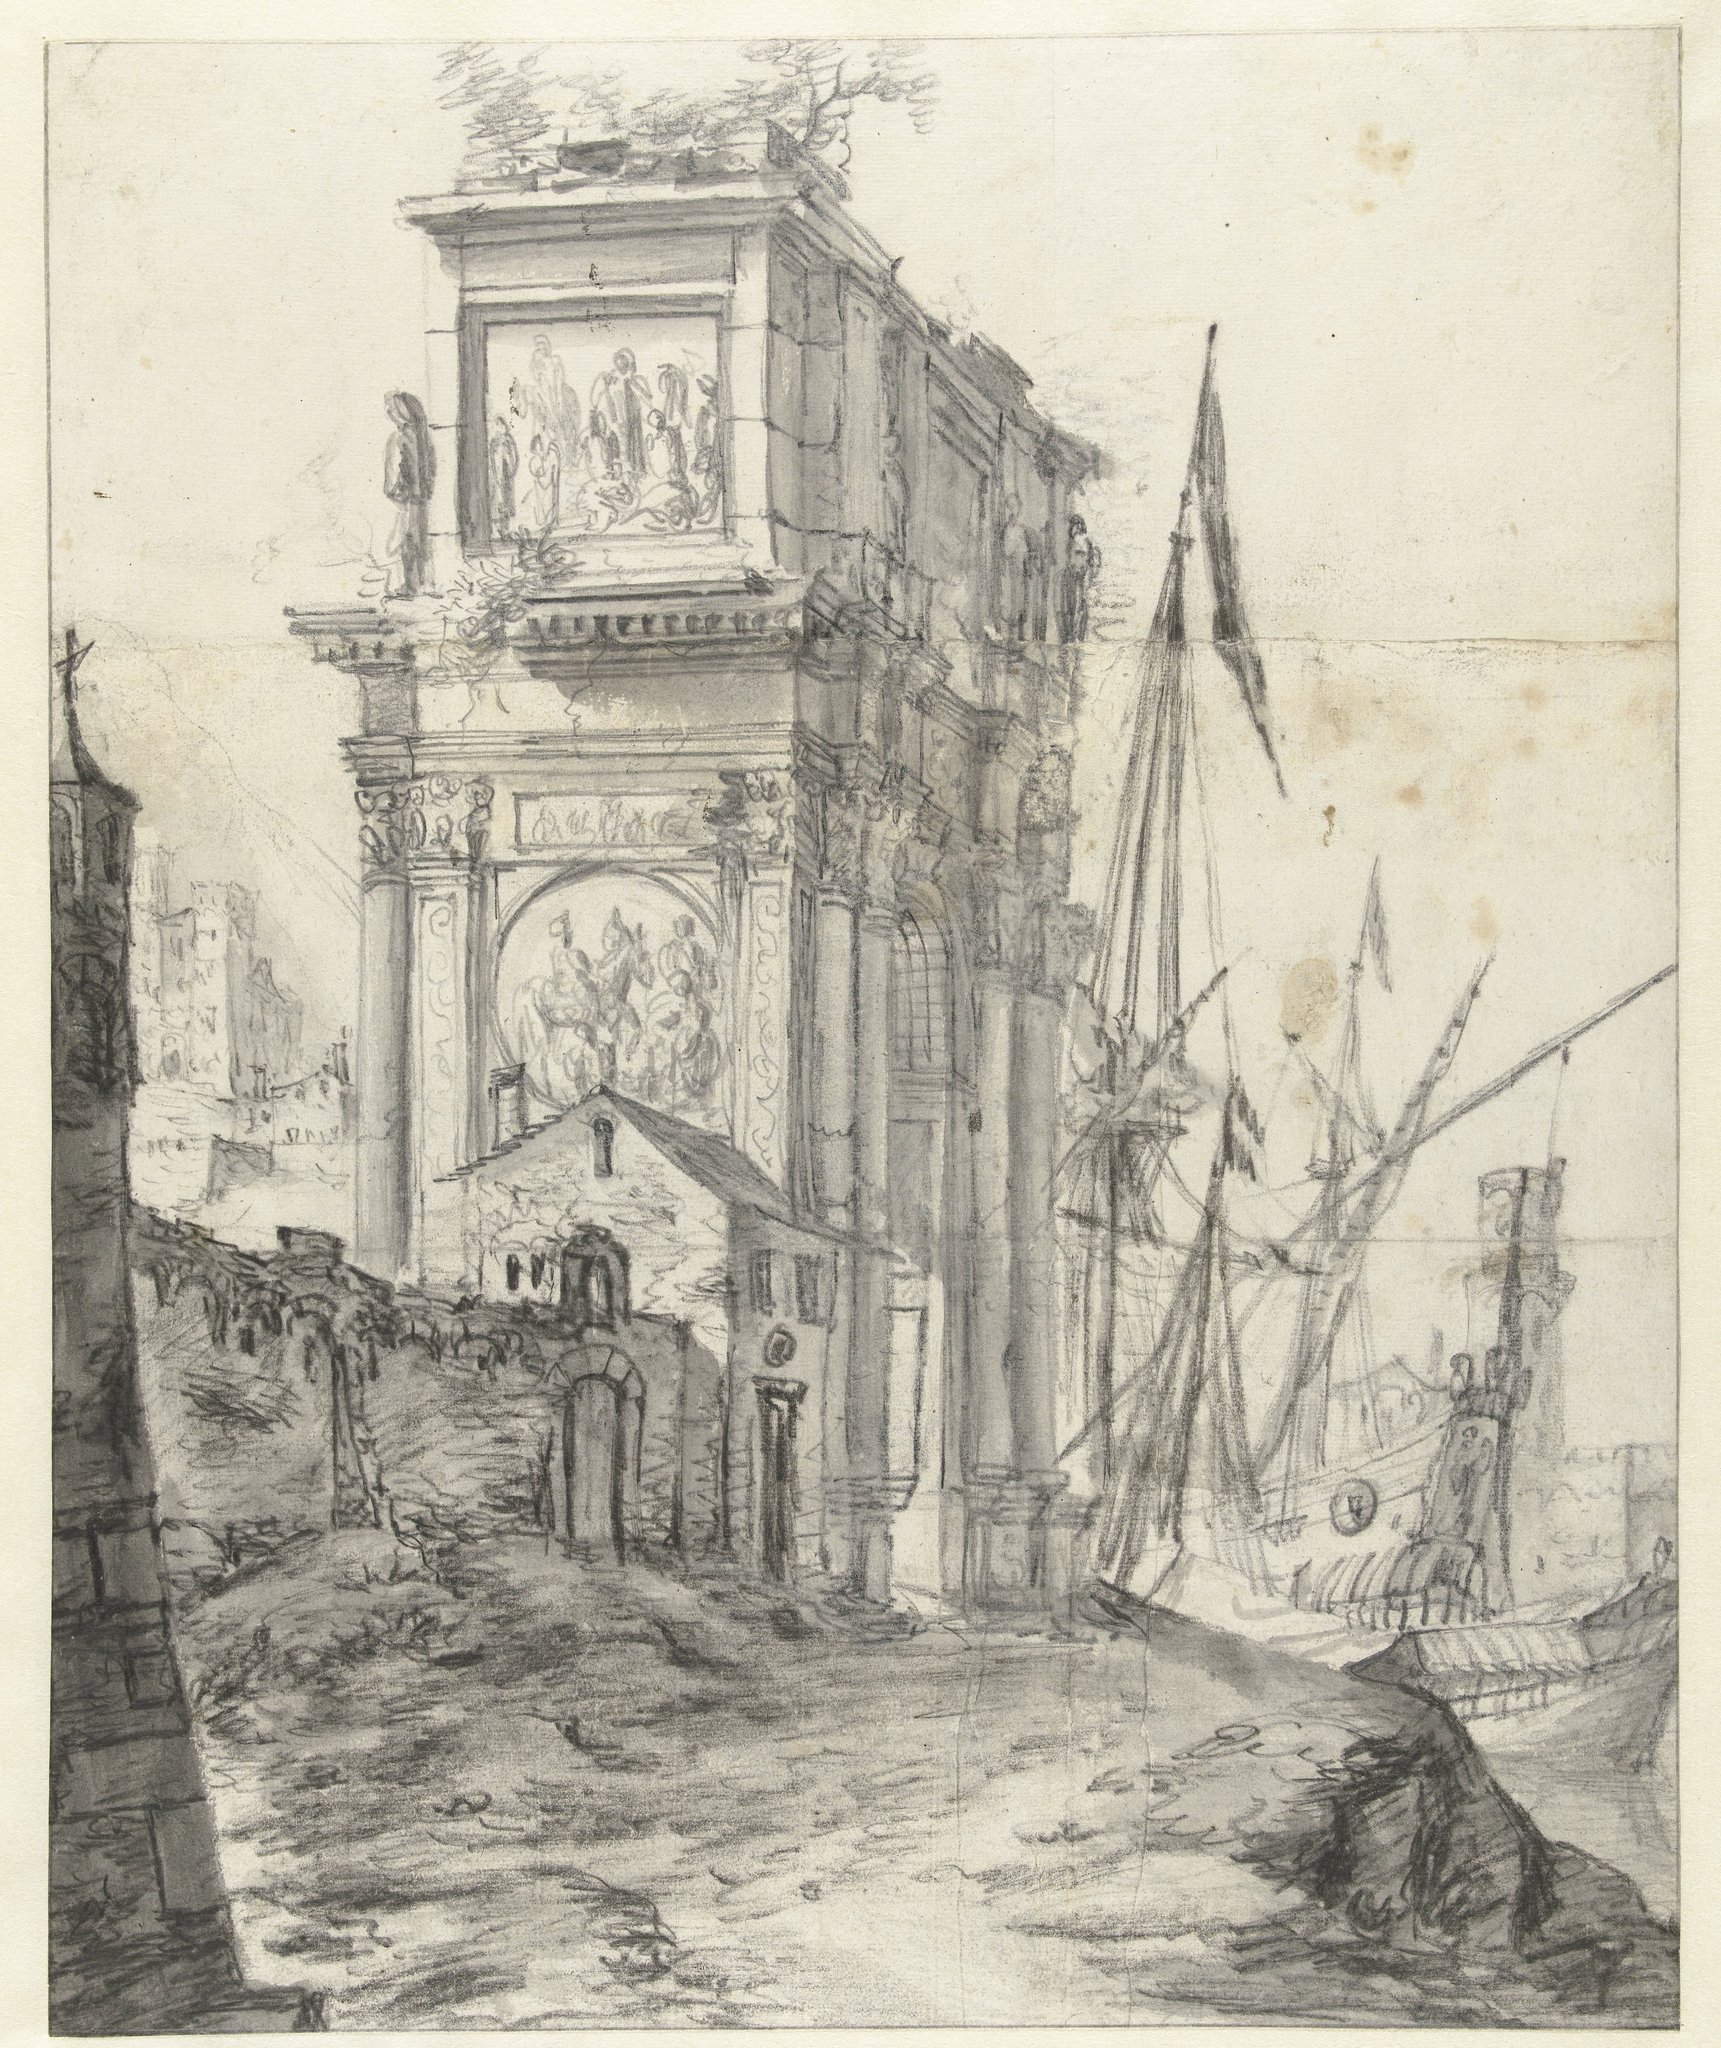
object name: drawing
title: Capriccio met antieke triomfboog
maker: jan abrahamsz. beerstraten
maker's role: draughtsman, painter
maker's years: 1622-1666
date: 1600-1699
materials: chalk, graphite, paper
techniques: brush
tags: harbour, sailing-ship, sailing-boat, ruin of a building ~ architecture, triumphal arch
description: Fantasiegezicht op haven met antieke triomfboog en zeilschip.